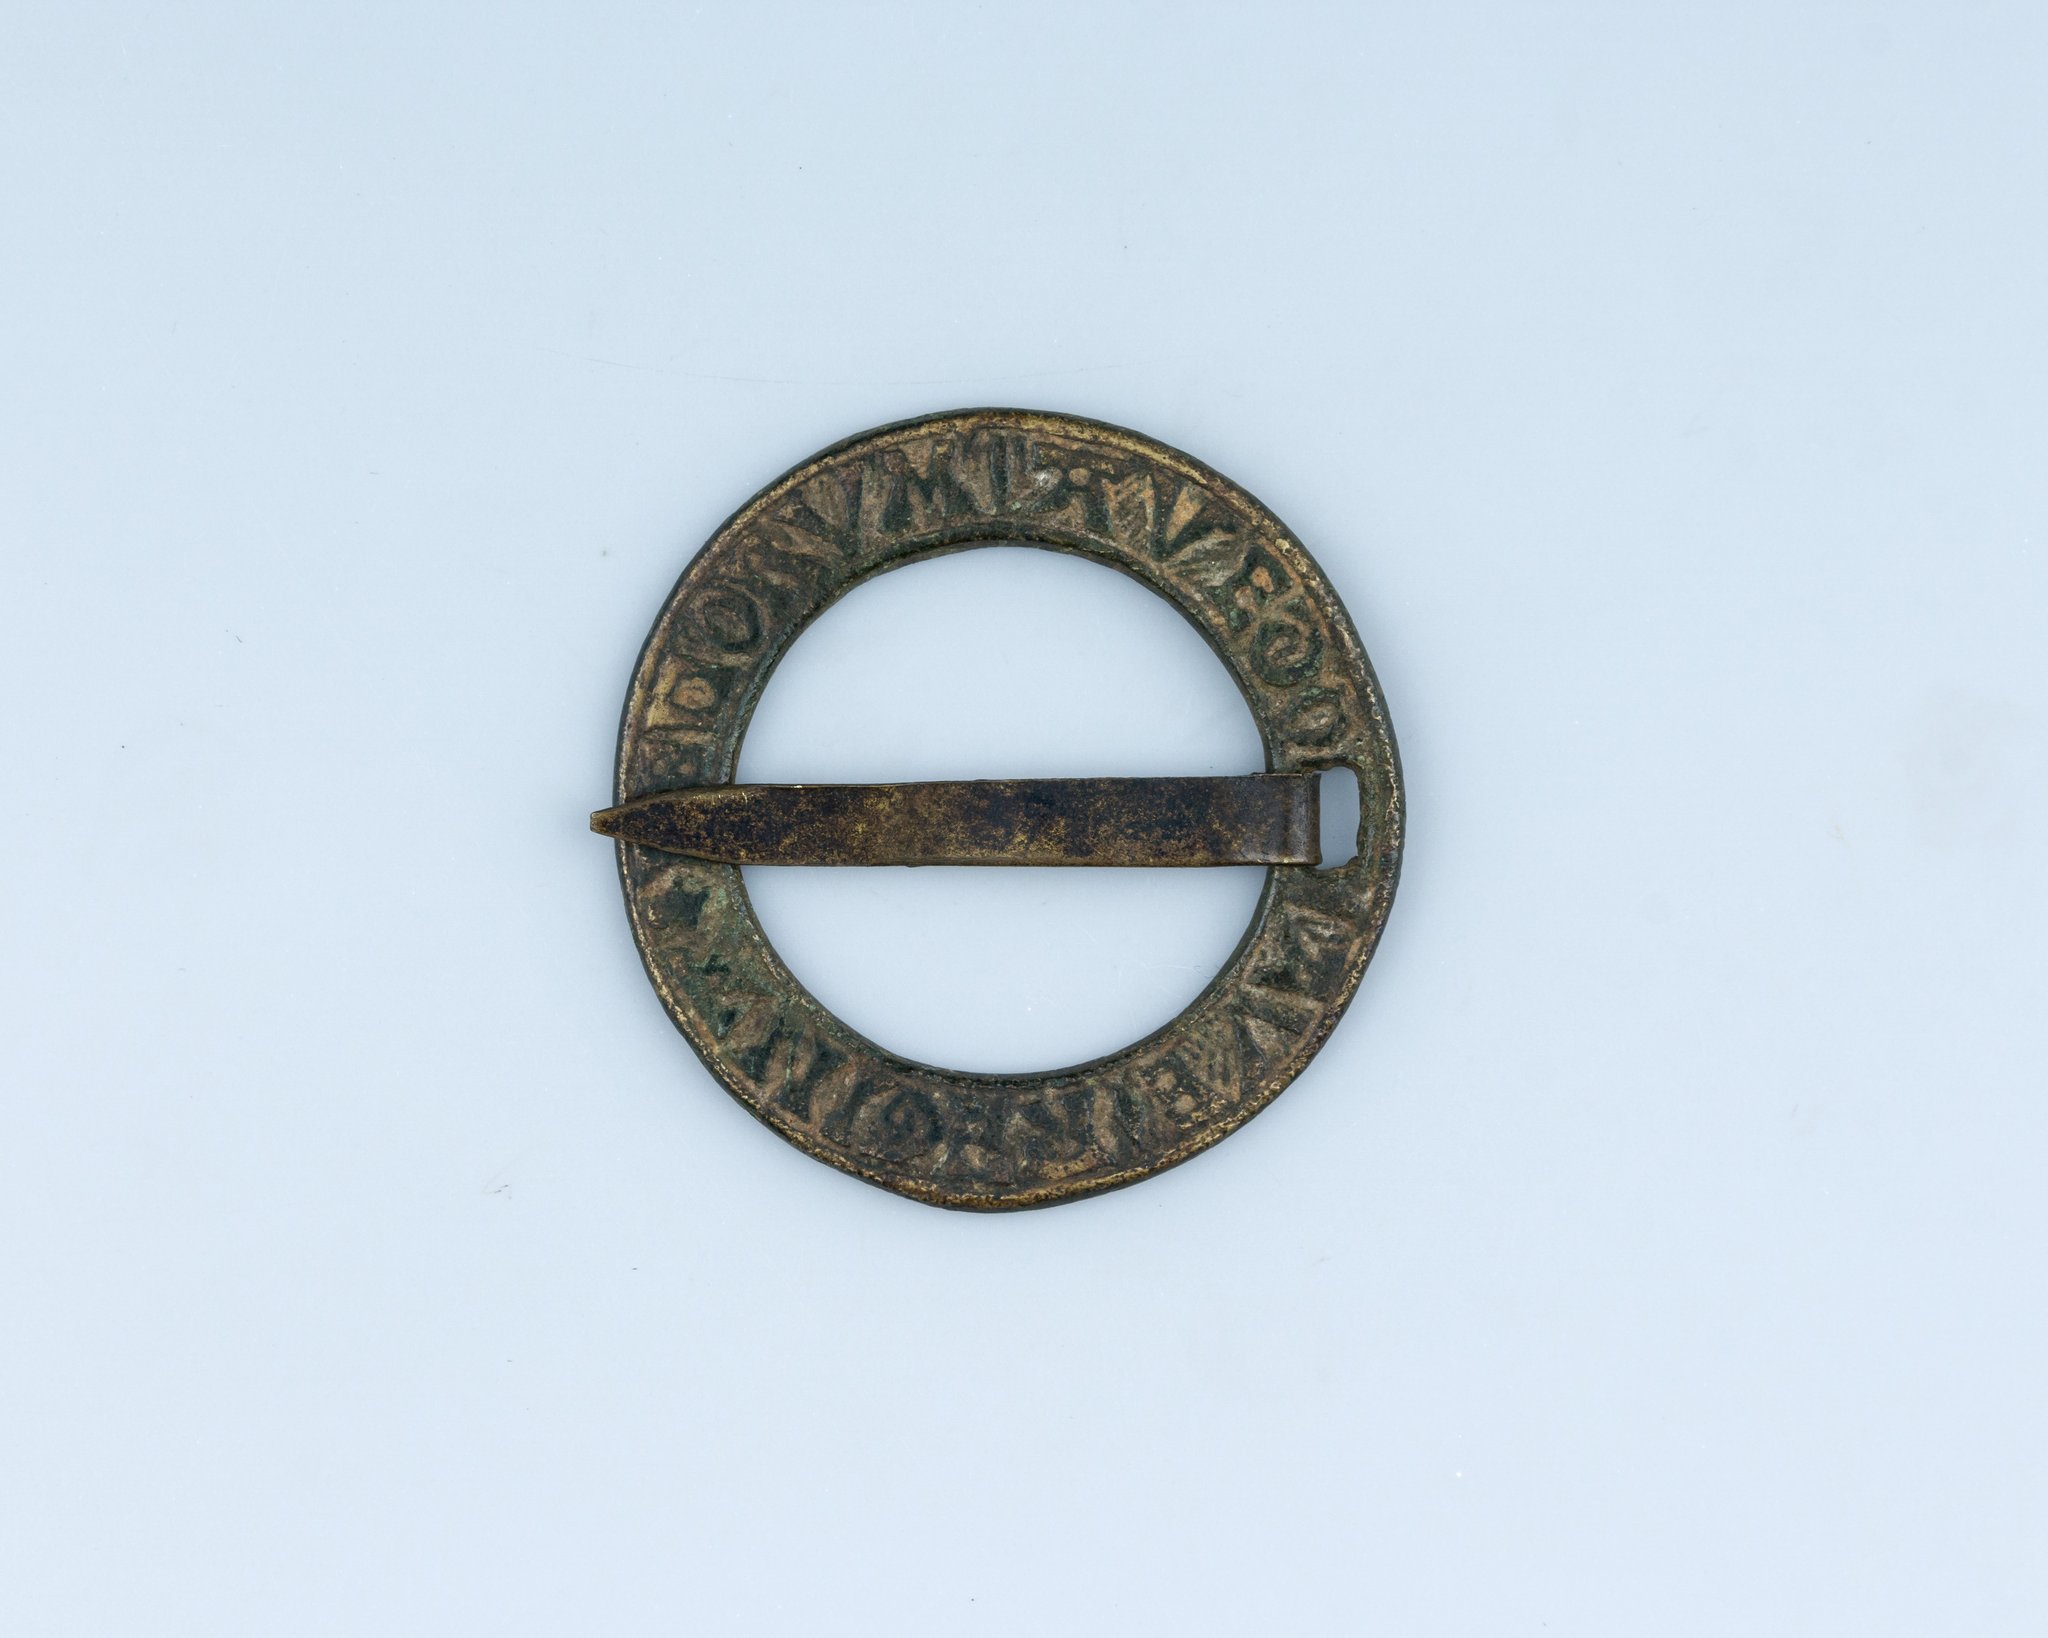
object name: buckle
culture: european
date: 1401-1700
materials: bronze, patina